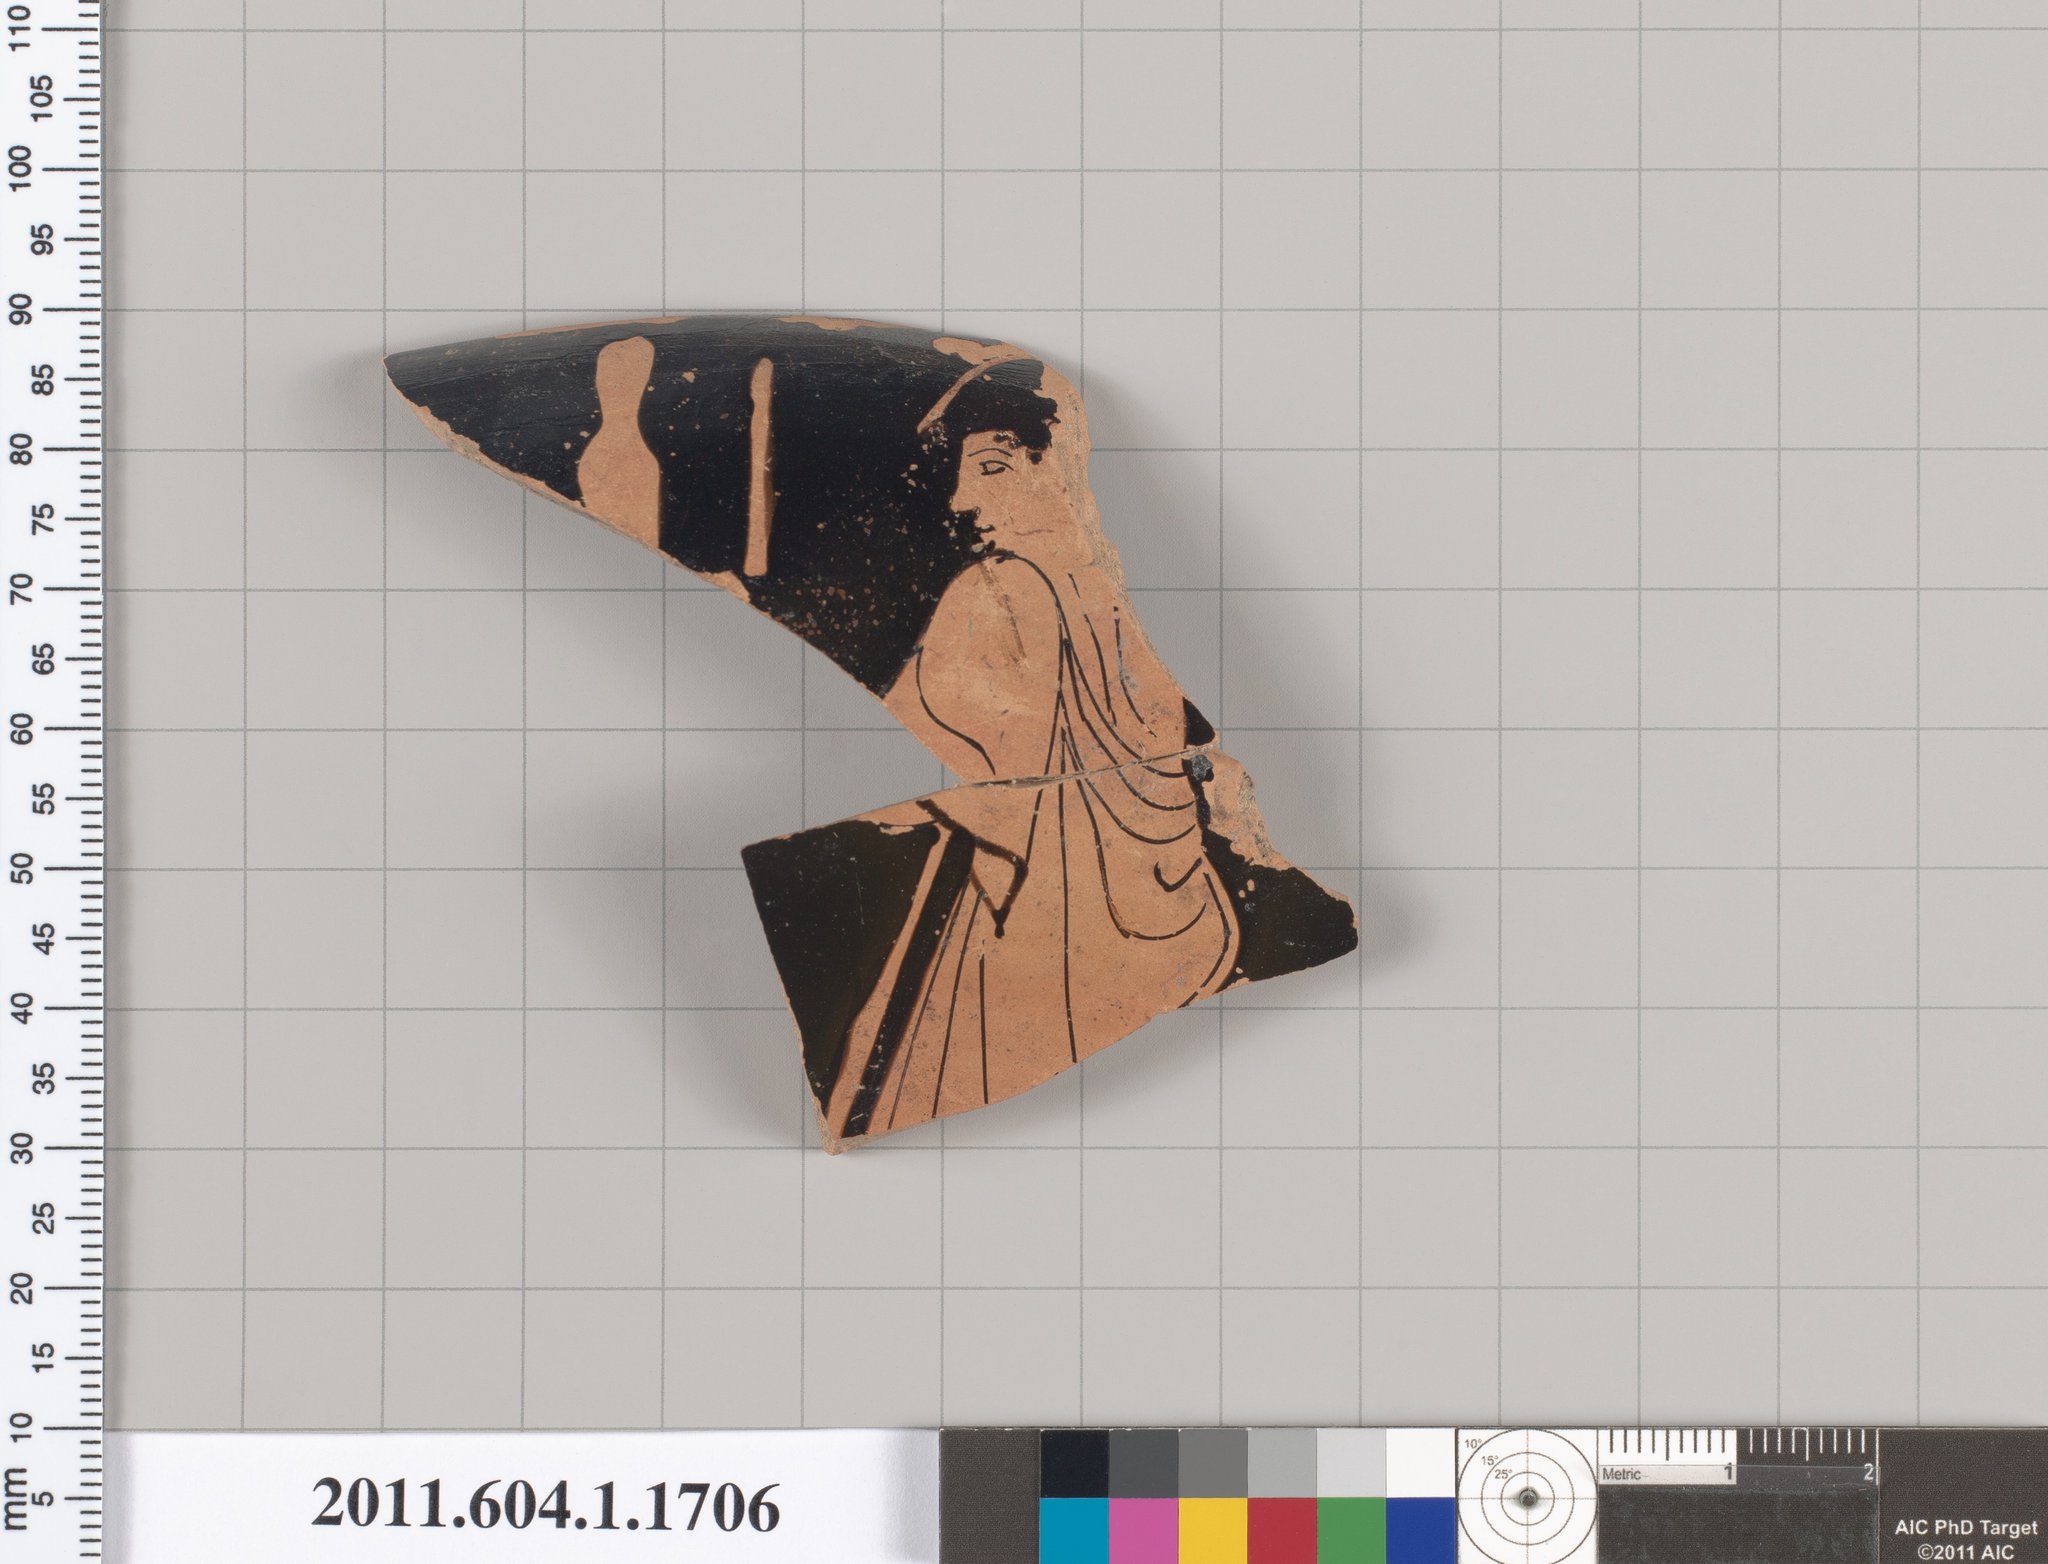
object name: kylix fragment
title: Terracotta rim fragment of a kylix (drinking cup)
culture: greek, attic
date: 470-460 BCE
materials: terracotta